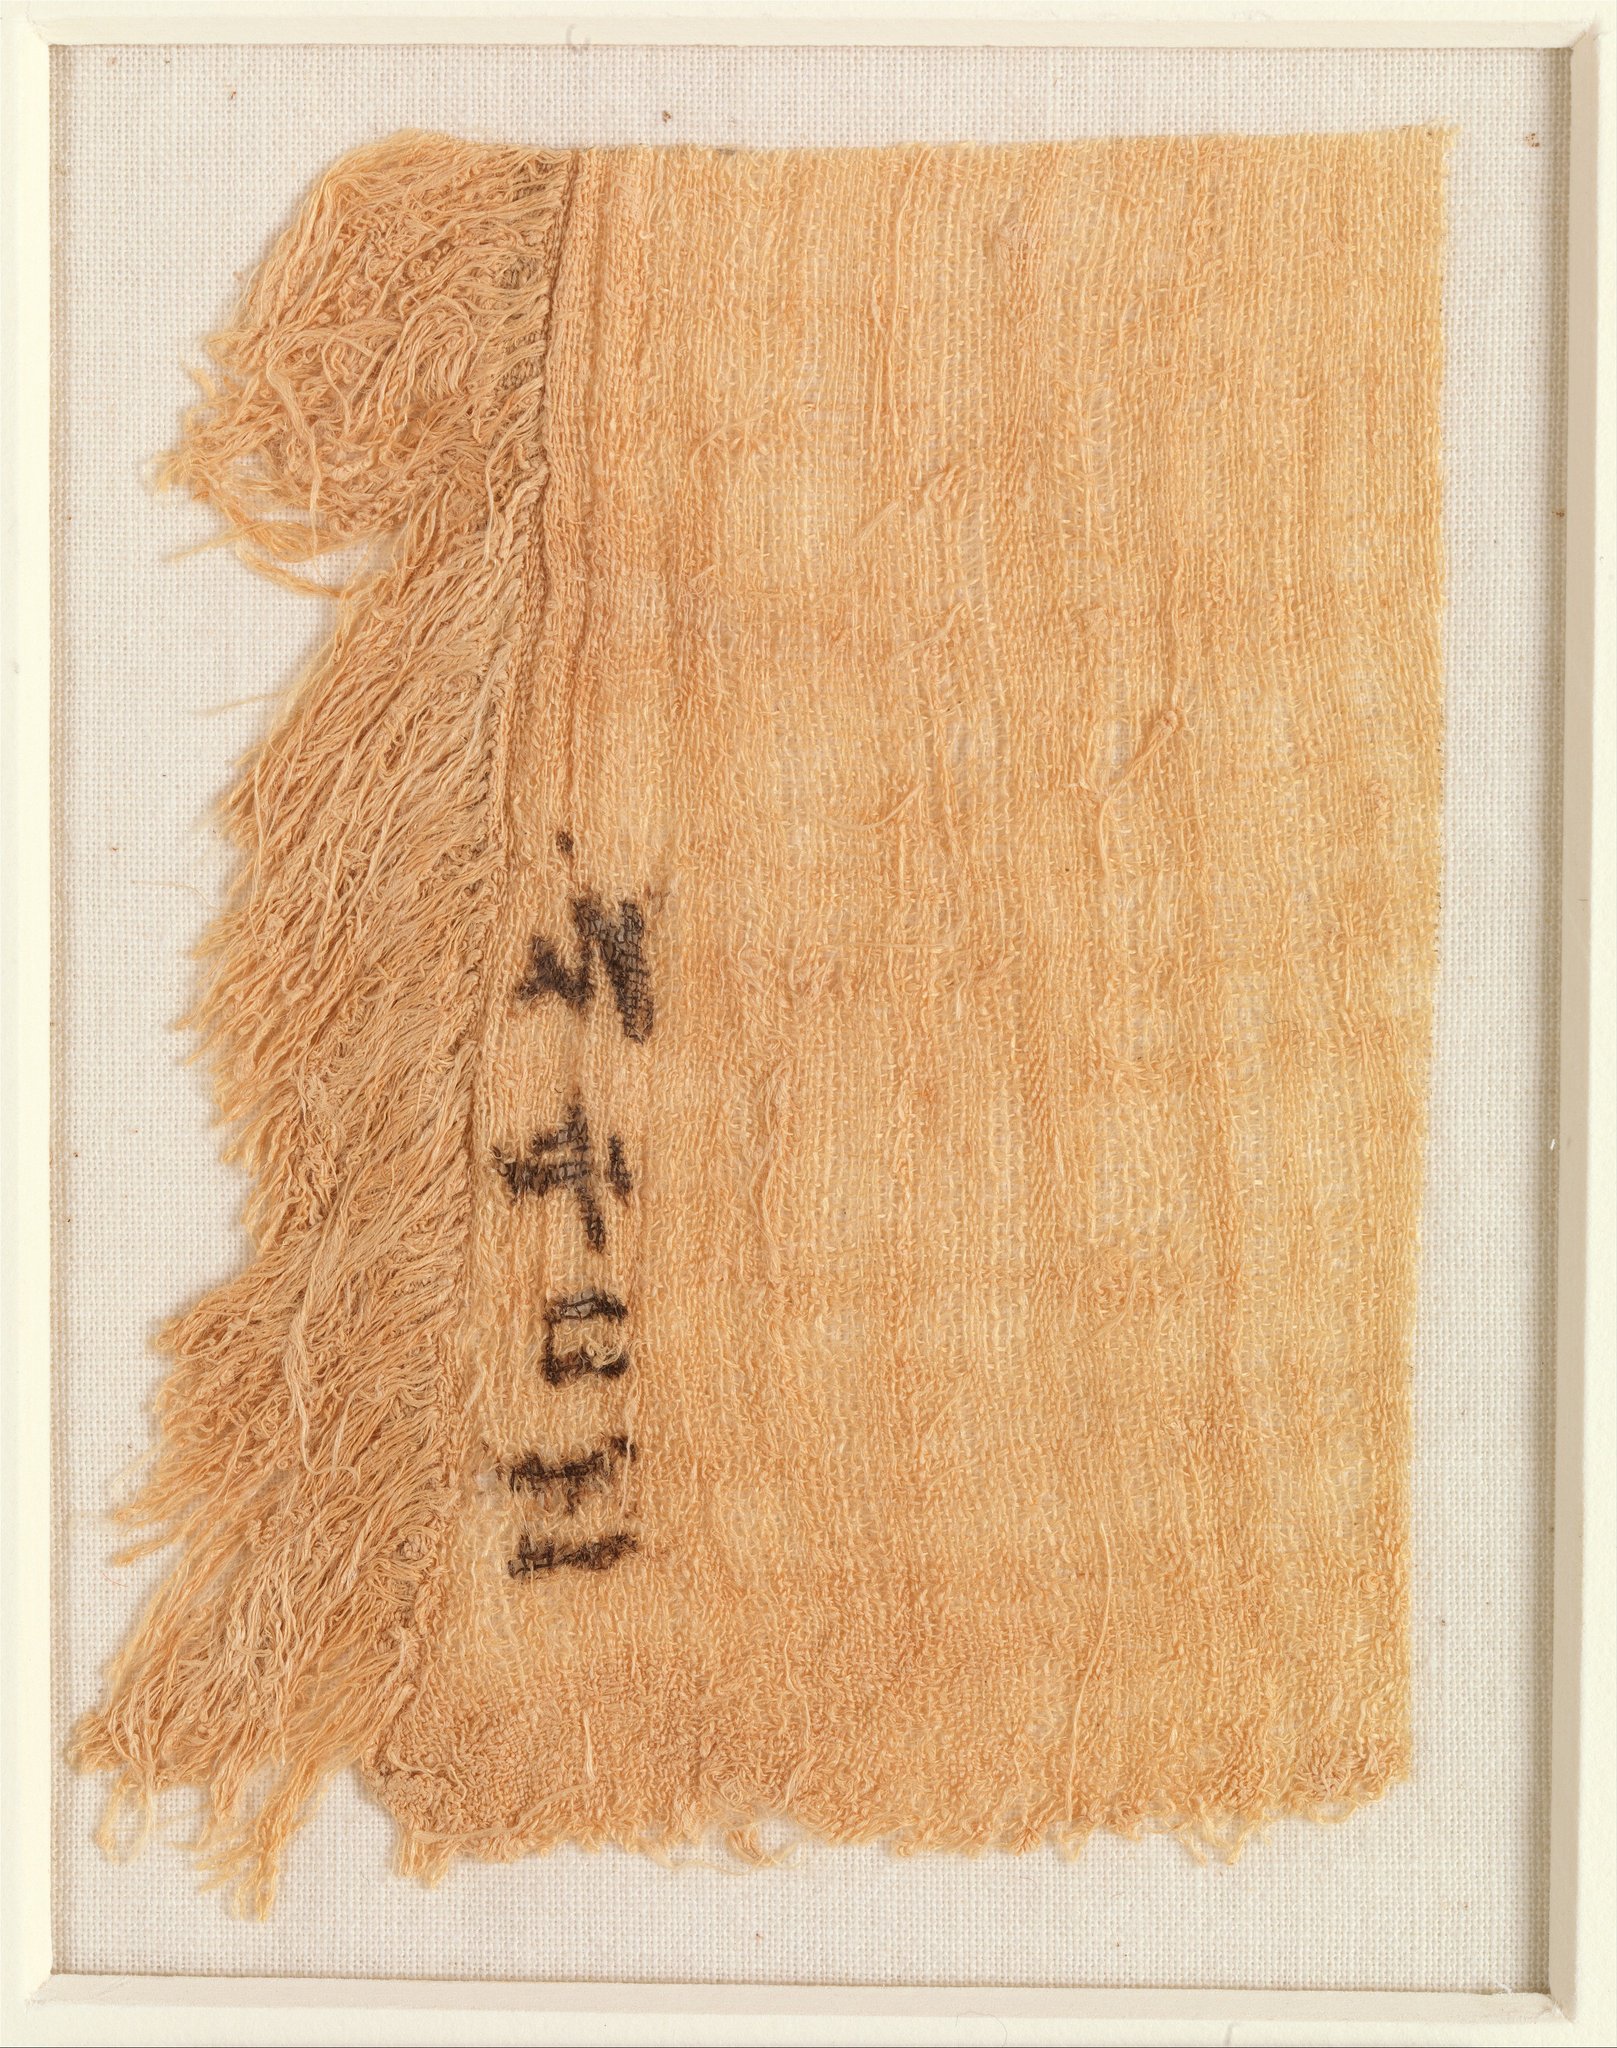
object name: linen mark, wah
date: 1981-1975 BCE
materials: linen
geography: egypt